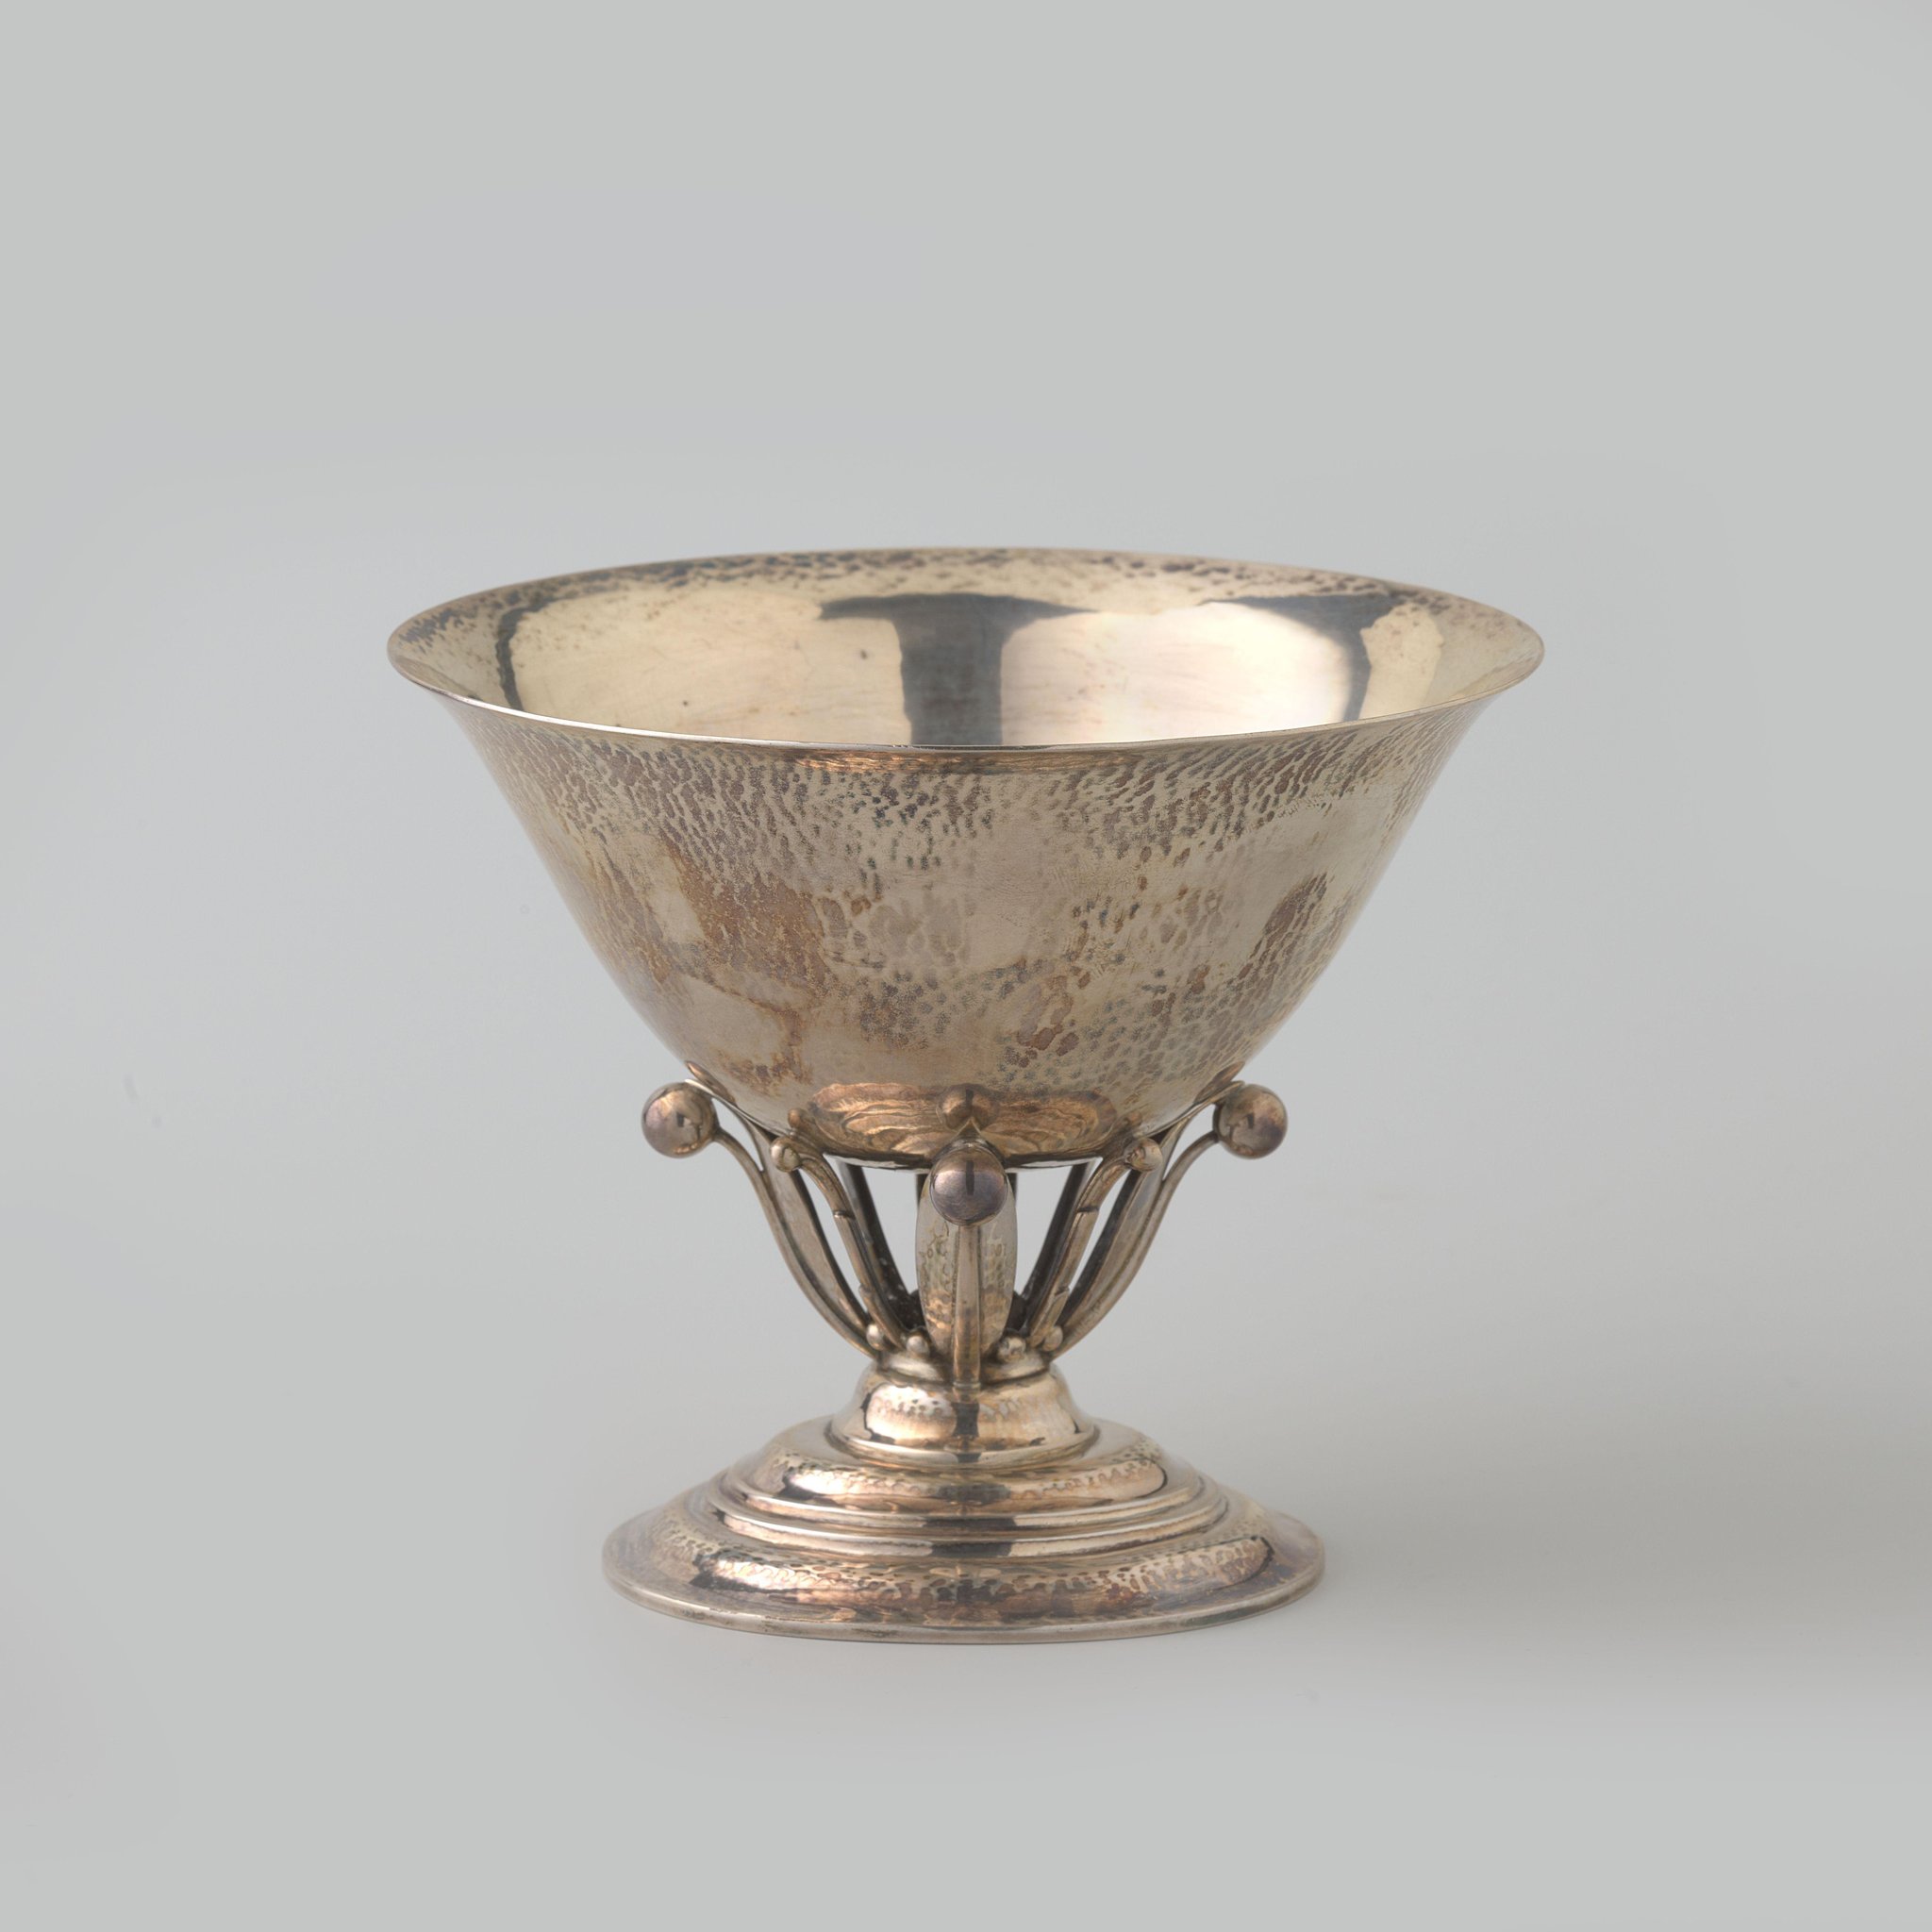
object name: coupe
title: Coupe van zilver met meervoudig gelede gewelfde ovale voetdie van de gewelfde bak met hamerslag-structuur wordt gescheiden door een opengwerkt gedeelte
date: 1910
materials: silver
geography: copenhagen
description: Coupe van zilver. De gewelfde ovale voet is meervoudig geleed en wordt gescheiden van de bak door een opengewerkt gedeelte. Het ronde vat heeft een gewelfde wand en hamerslag-structuur.